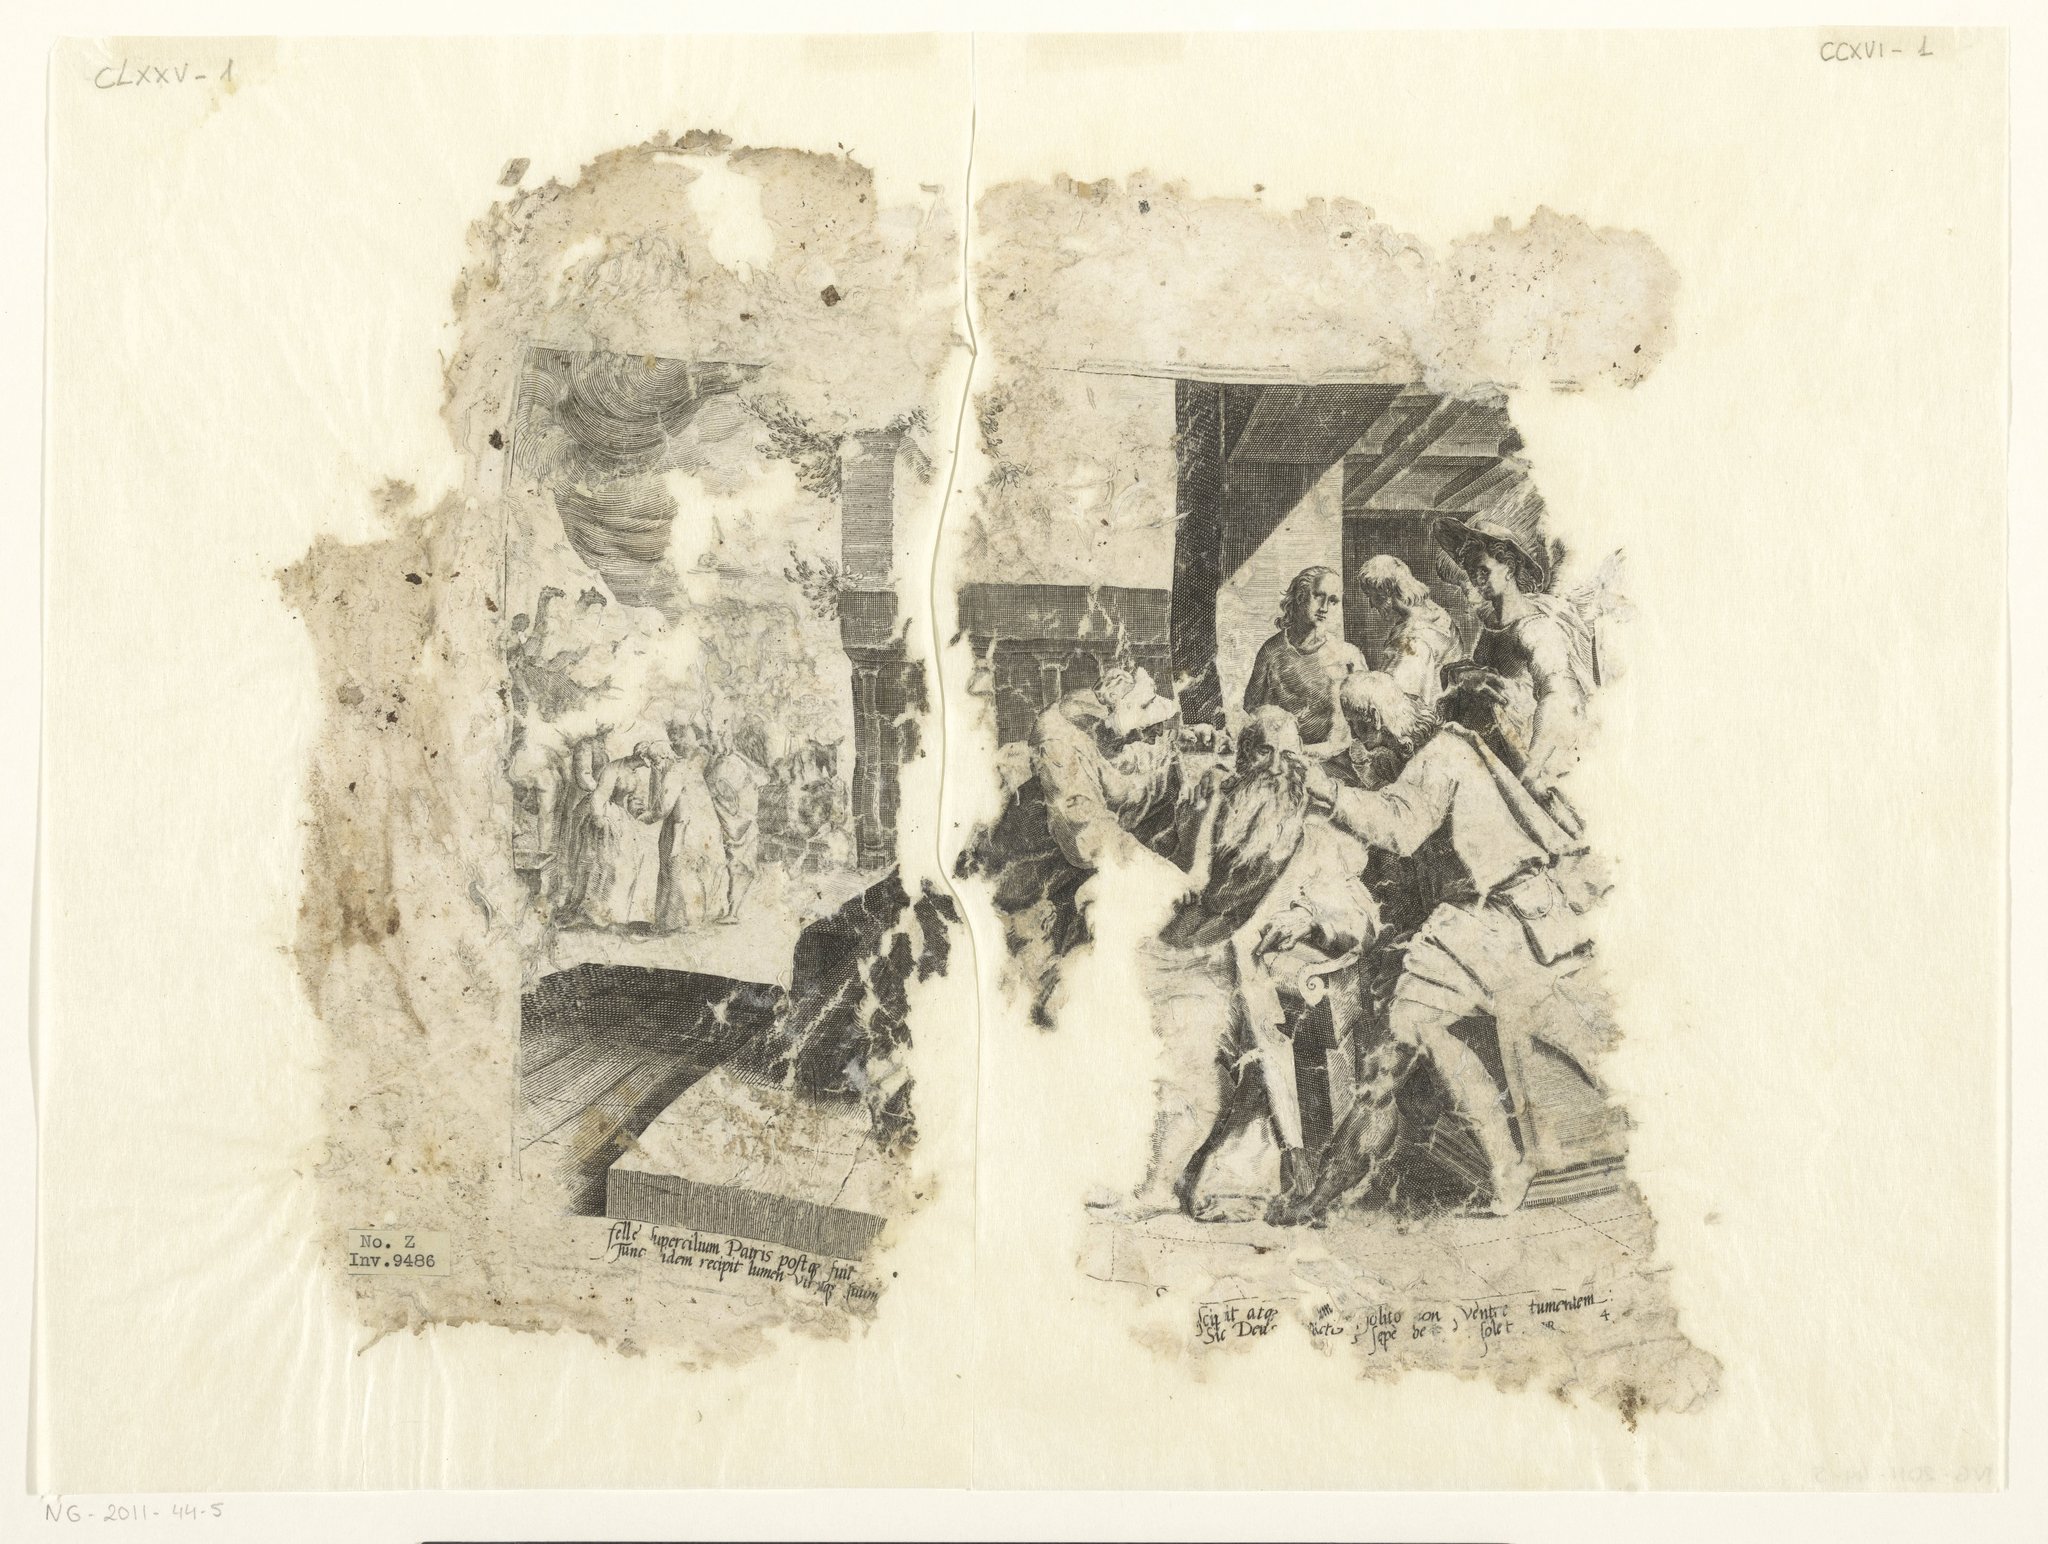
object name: print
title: Geschiedenis van Tobias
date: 1580-1596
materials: paper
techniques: engraving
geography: amsterdam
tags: the healing of tobit: tobias puts the gall of the fish on his father's eyes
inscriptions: inscription: ‘No. Z Inv 9486’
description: De prenten in de Nova Zembla collectie zijn tijdens een expeditie van Willem Barendsz en Jacob van Heemskerk in 1596-1597 noodgedwongen in het winterkamp, het ‘Behouden Huis’, op het eiland achtergelaten. De prenten waren in één of meerdere stapels als handelswaar meegenomen vanuit Amsterdam. Bijna drie eeuwen later, in 1871, keerde de Noor Elling Carlsen terug naar Nova Zembla en vond daar de restanten van het ‘Behouden Huis, inclusief een groot deel van de inventaris. Een deel van de prenten, in de vorm van aaneengekoekte kluiten, werd toen ook teruggevonden. De papierkluiten waren soms op meerdere plekken gebroken. Tussen 1975-1979 zijn de prenten van elkaar gescheiden. Dit leverde in totaal ca. 1000 fragmenten van ca. 400 afdrukken van ca. 150 verschillende prenten op. Voor zover mogelijk zijn de fragmenten samengevoegd en zijn de prenten gereconstrueerd.